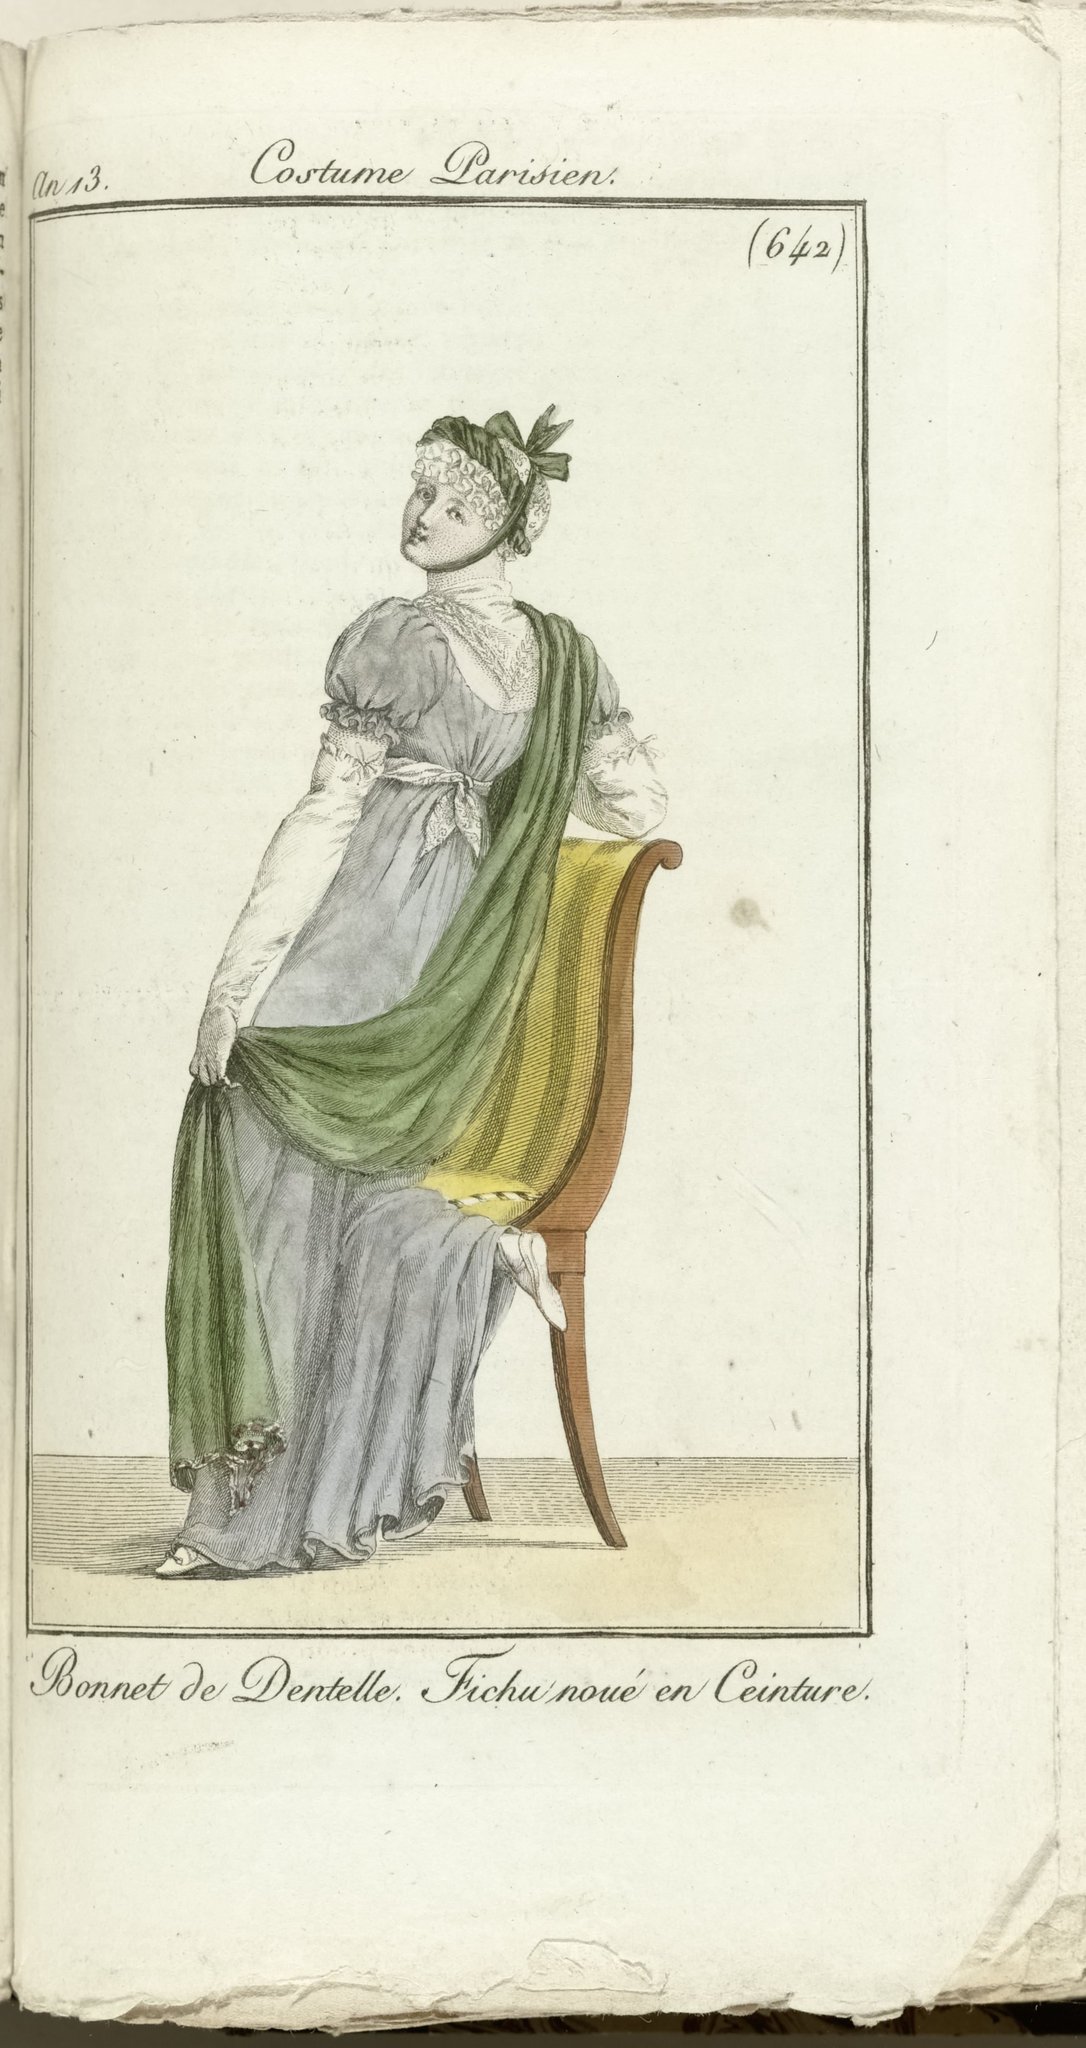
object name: fashion print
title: Journal des Dames et des Modes, Costume Parisien, 1805, An 13 (642) Bonnet de Dentelle...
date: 1805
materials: paper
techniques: engraving, hand coloring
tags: gloves, mittens (long gloves) (+ women's clothes), neck-gear ~ clothing (shawl) (+ women's clothes), head-gear (bonnet) (+ women's clothes), fashion plates, dress, gown (+ women's clothes), piece of clothing covering the breast or décolleté (fichu) (+ women's clothes)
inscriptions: title: ‘Bonnet de Dentelle. Fichu noué en Ceinture.’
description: Jonge vrouw., met één been leunend op een stoel, op de rug gezien. Ze draagt een paarse japon met korte pofmouwen en een wit fichu dat overgaat in ceintuur. Op het hoofd een bonnet van kant. Groene lange sjaal over de schouder. Lange witte handschoenen.